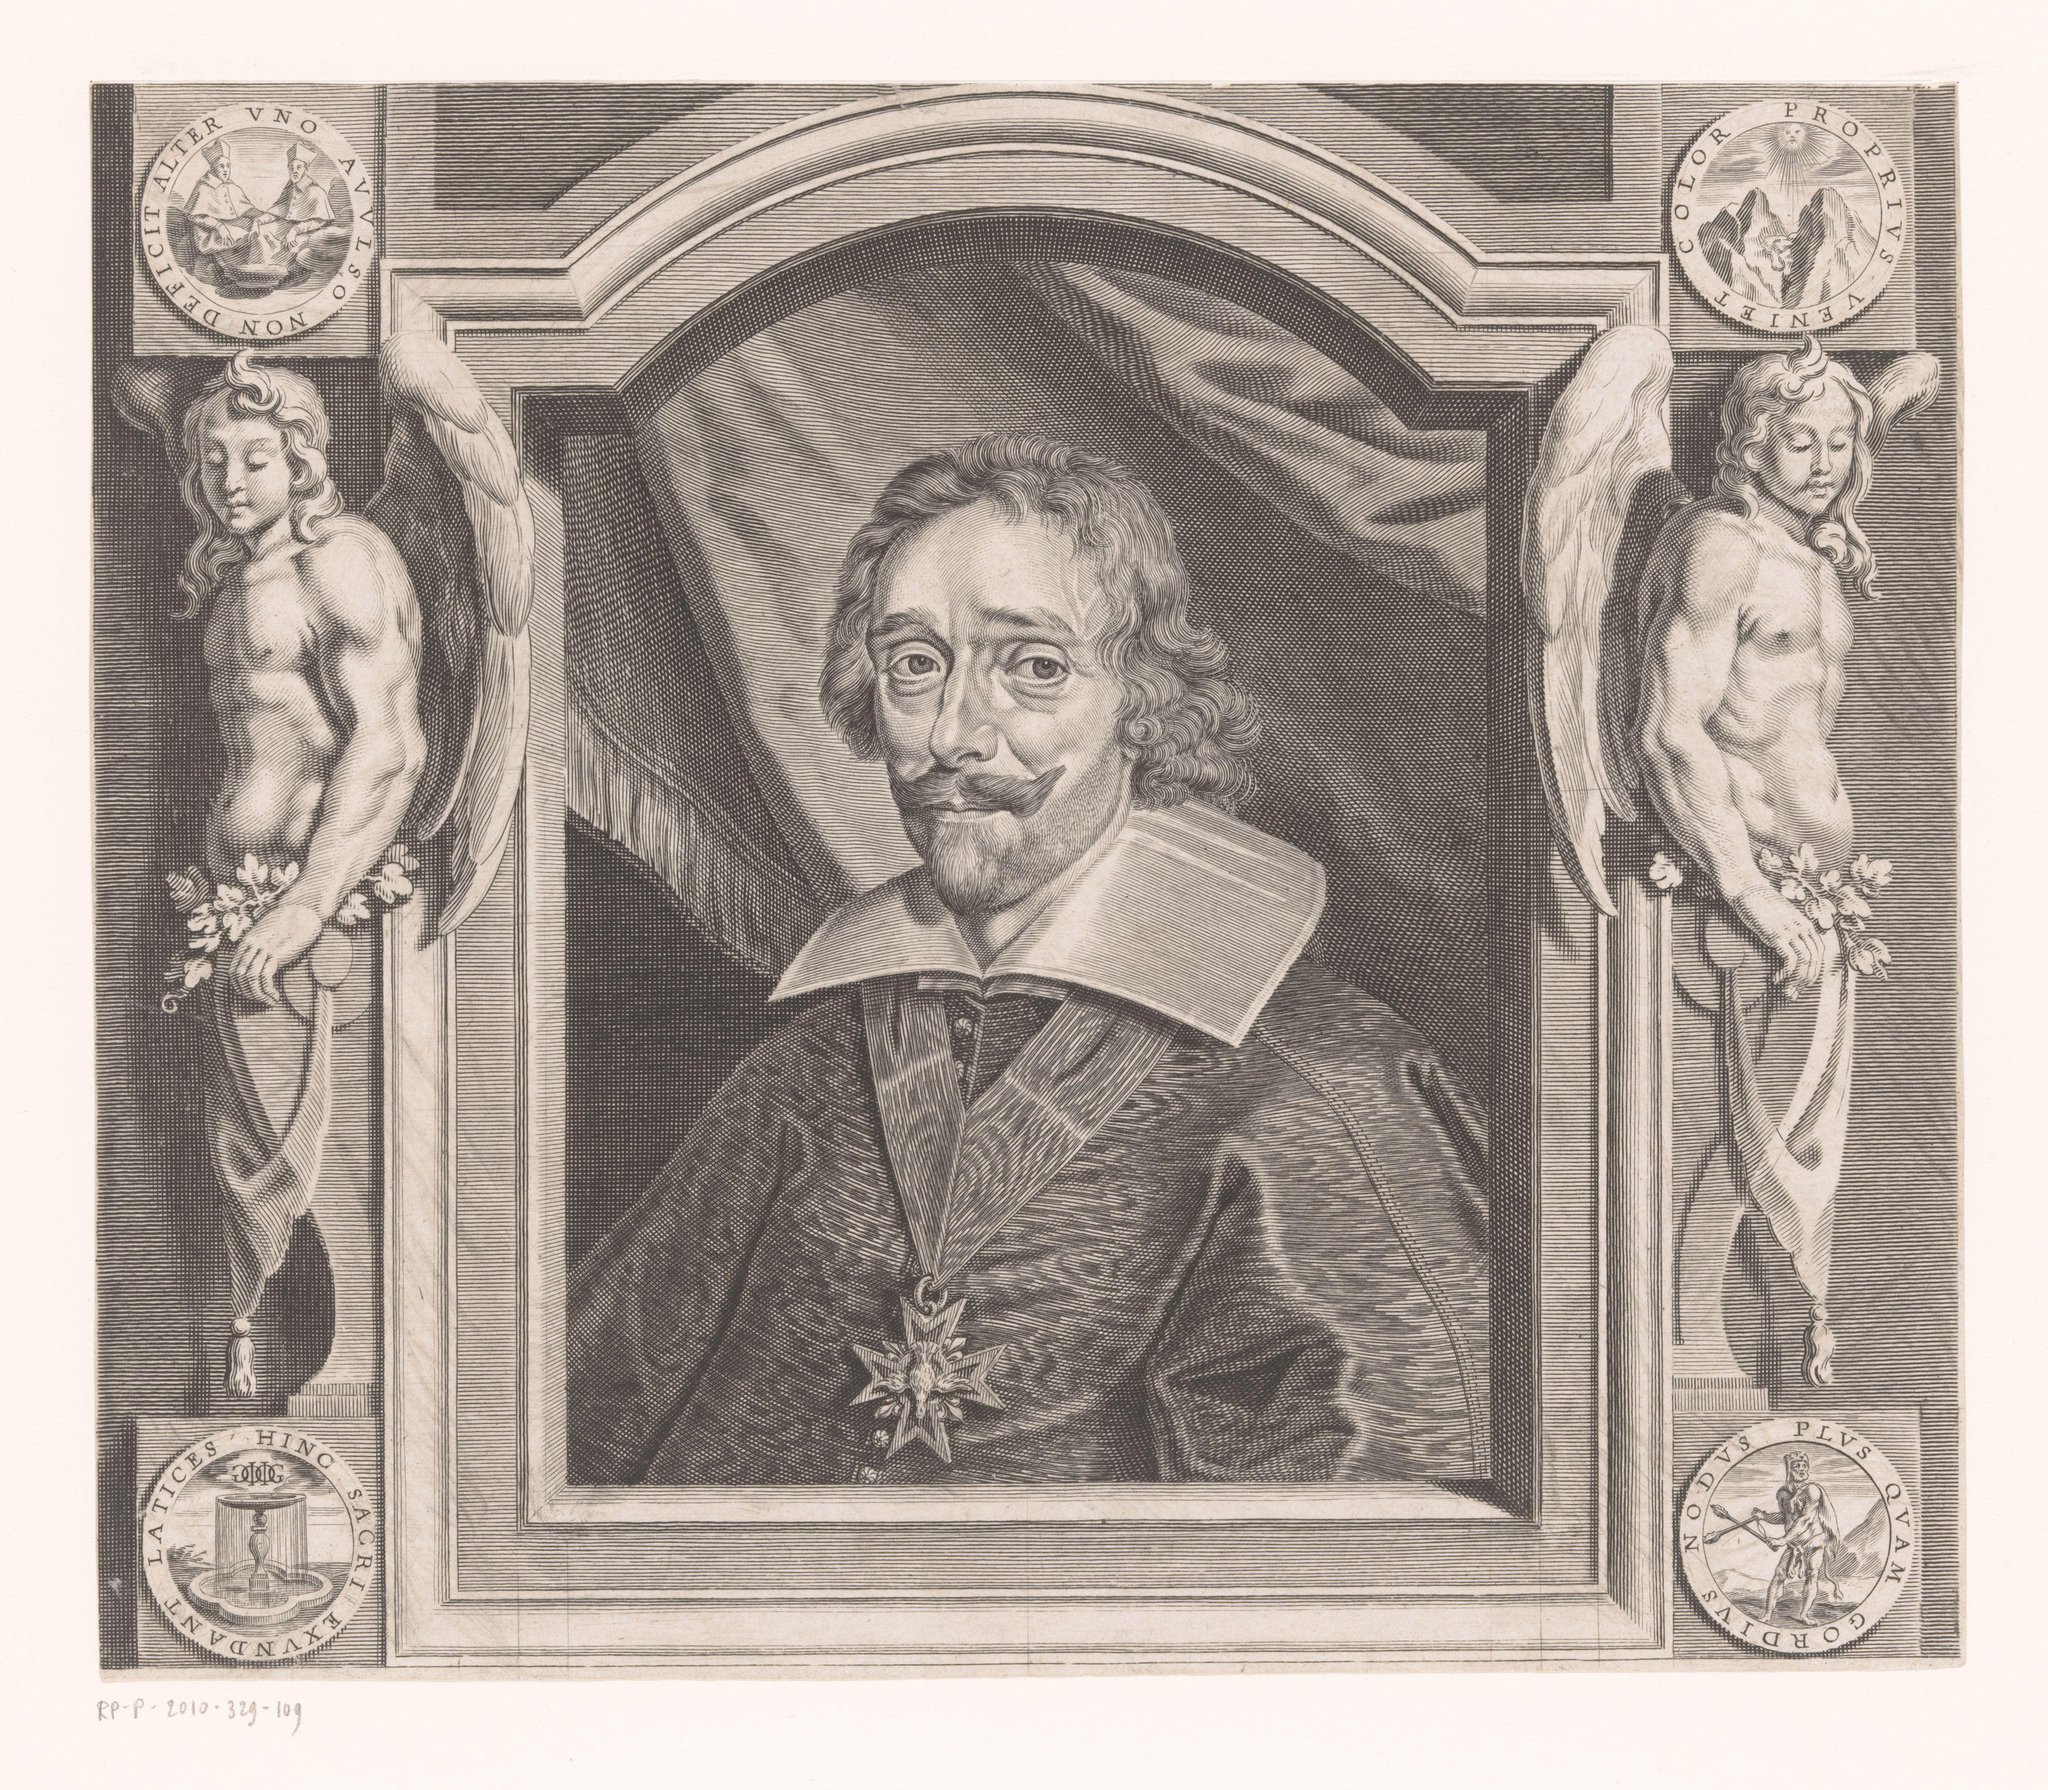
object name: print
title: Portret van Jean-François Paul de Gondi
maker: michel lasne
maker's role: print maker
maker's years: 1590-1667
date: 1600-1667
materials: paper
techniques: engraving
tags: cardinal, historical persons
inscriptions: collector's mark: Lugt 2228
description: Portret ten halven lijve, naar links, in een venster geflankeerd door twee gevleugelde hermen.